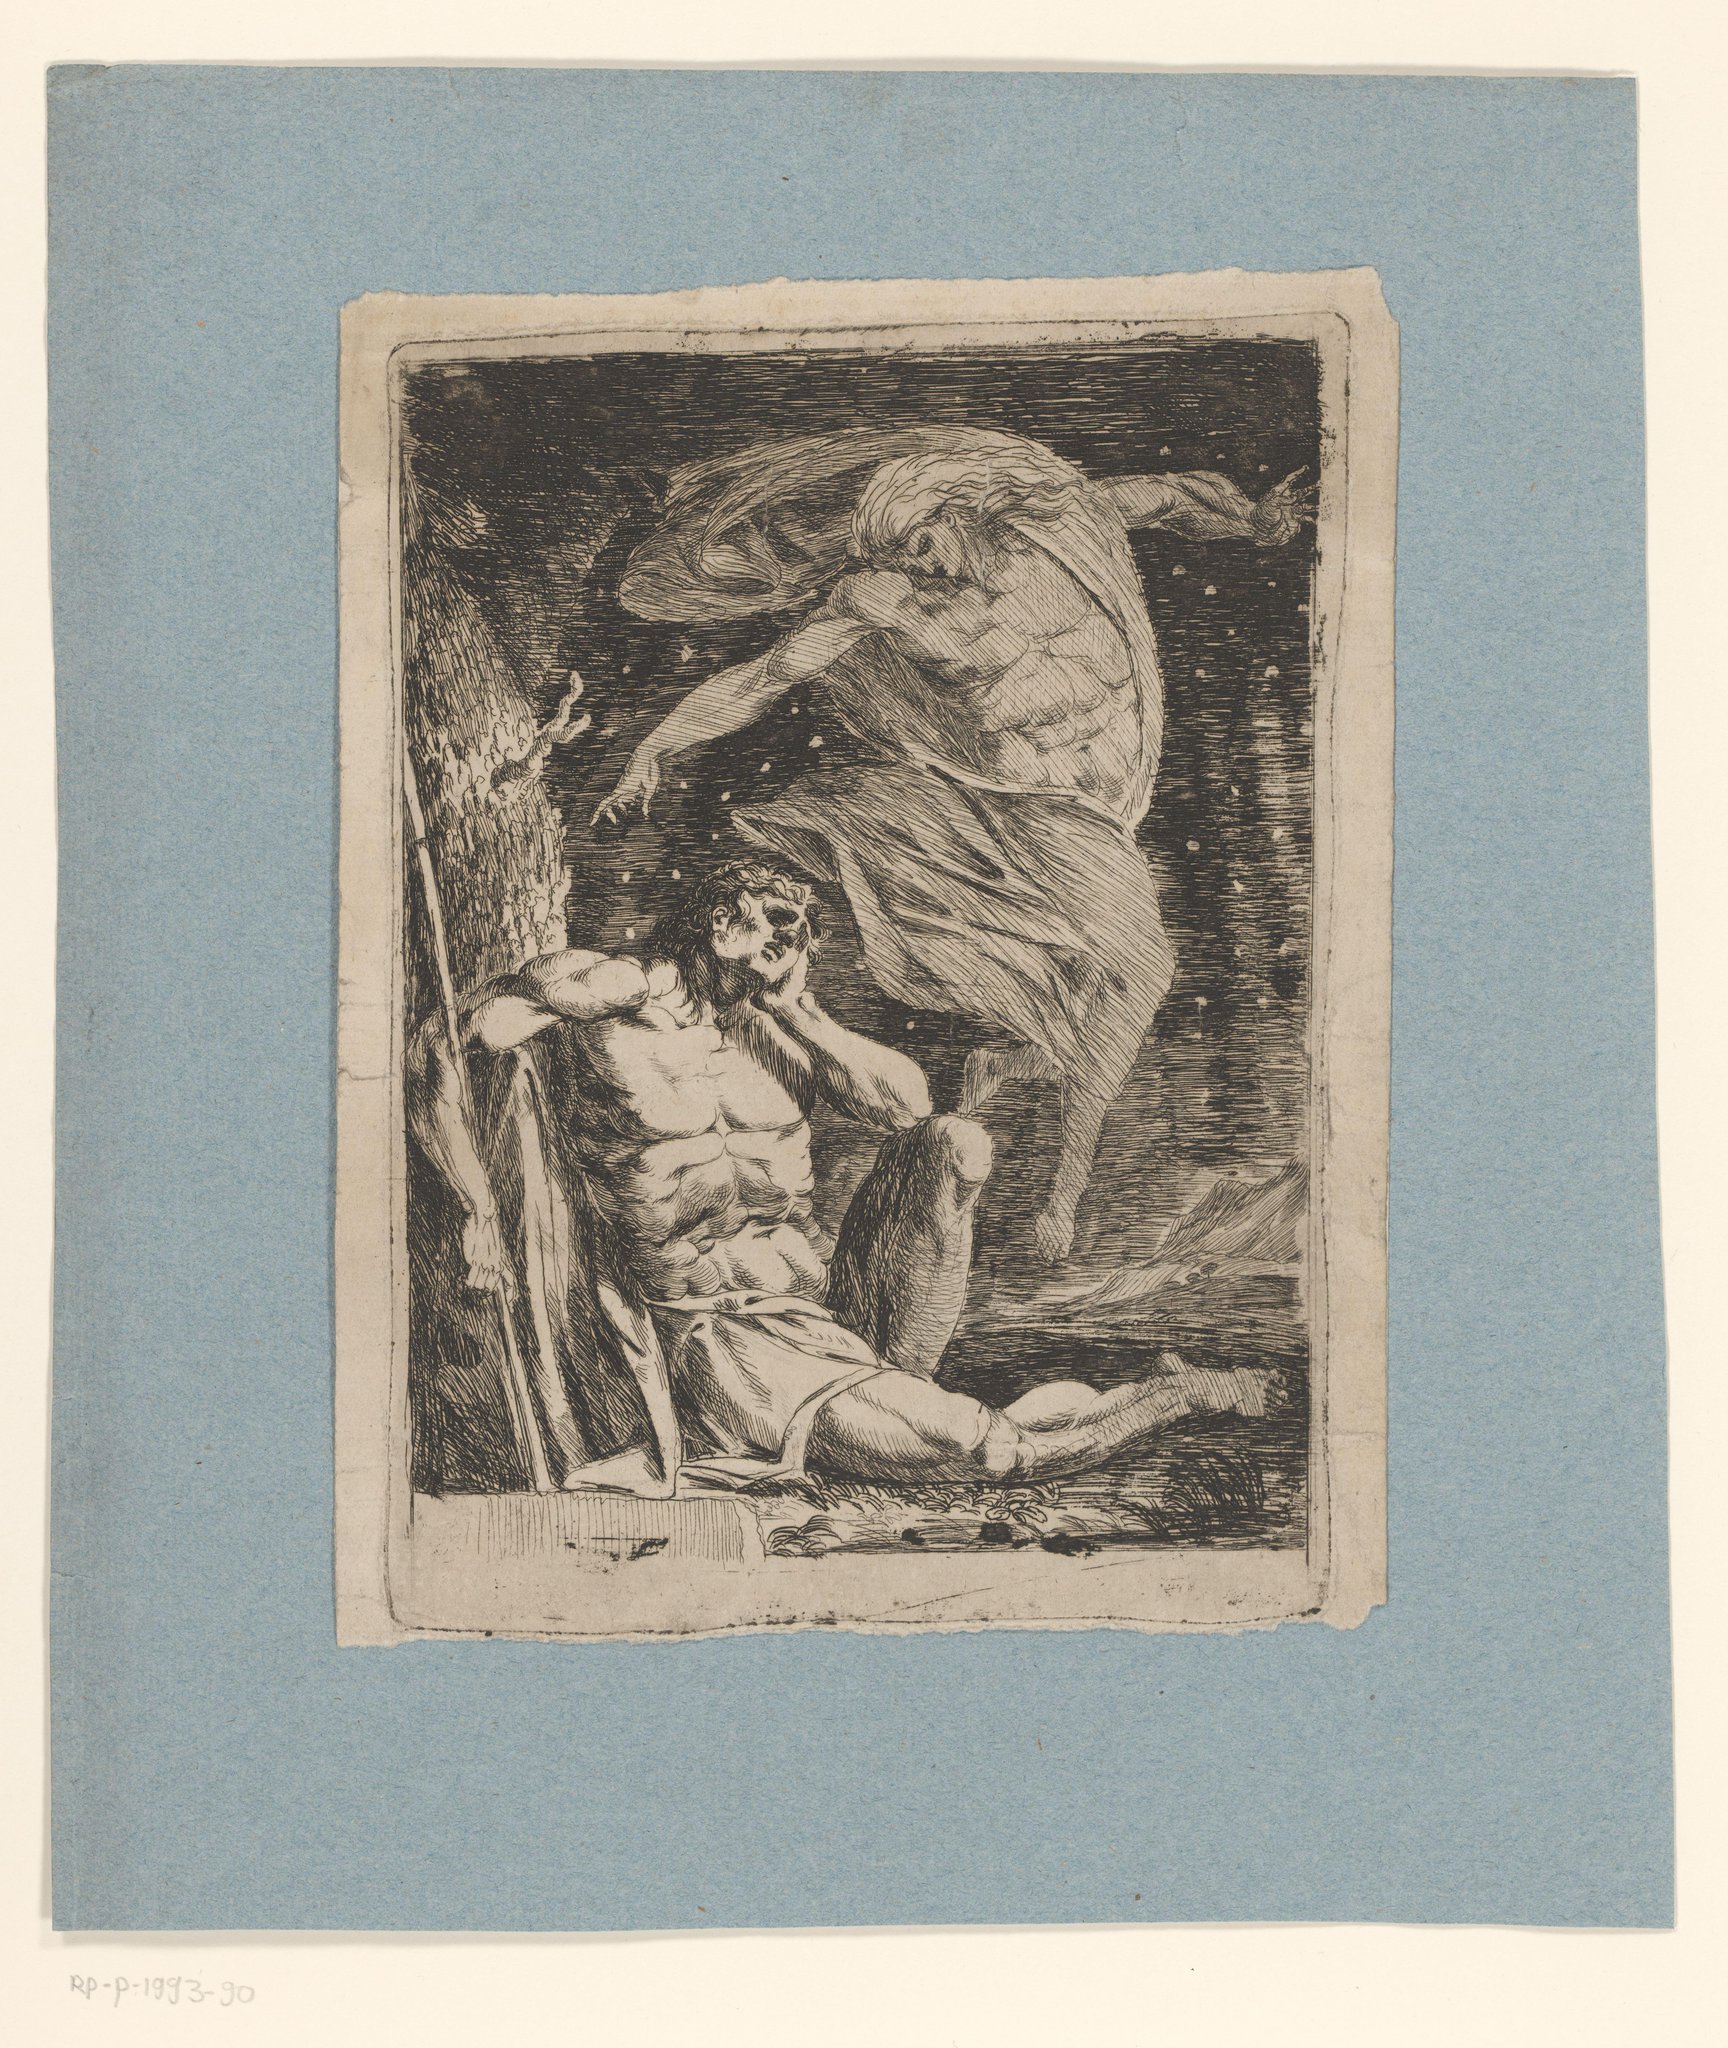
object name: print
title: Geest van Crugal verschijnt aan Connal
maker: alexander runciman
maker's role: draughtsman, print maker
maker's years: 1736-1785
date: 1770-1775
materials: paper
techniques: etching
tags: (scenes from) specific works of literature (with author, title), spirit, ghost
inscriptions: collector's mark: Lugt 2228, collector's mark: Lugt 2760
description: Deze prent is een illustratie gebaseerd op een scene uit boek twee van het Iers-Schotse heldenepos 'Ossian'. De gedichten zijn opgeschreven door James Macpherson en voor het eerst in 1761 uitgegeven.